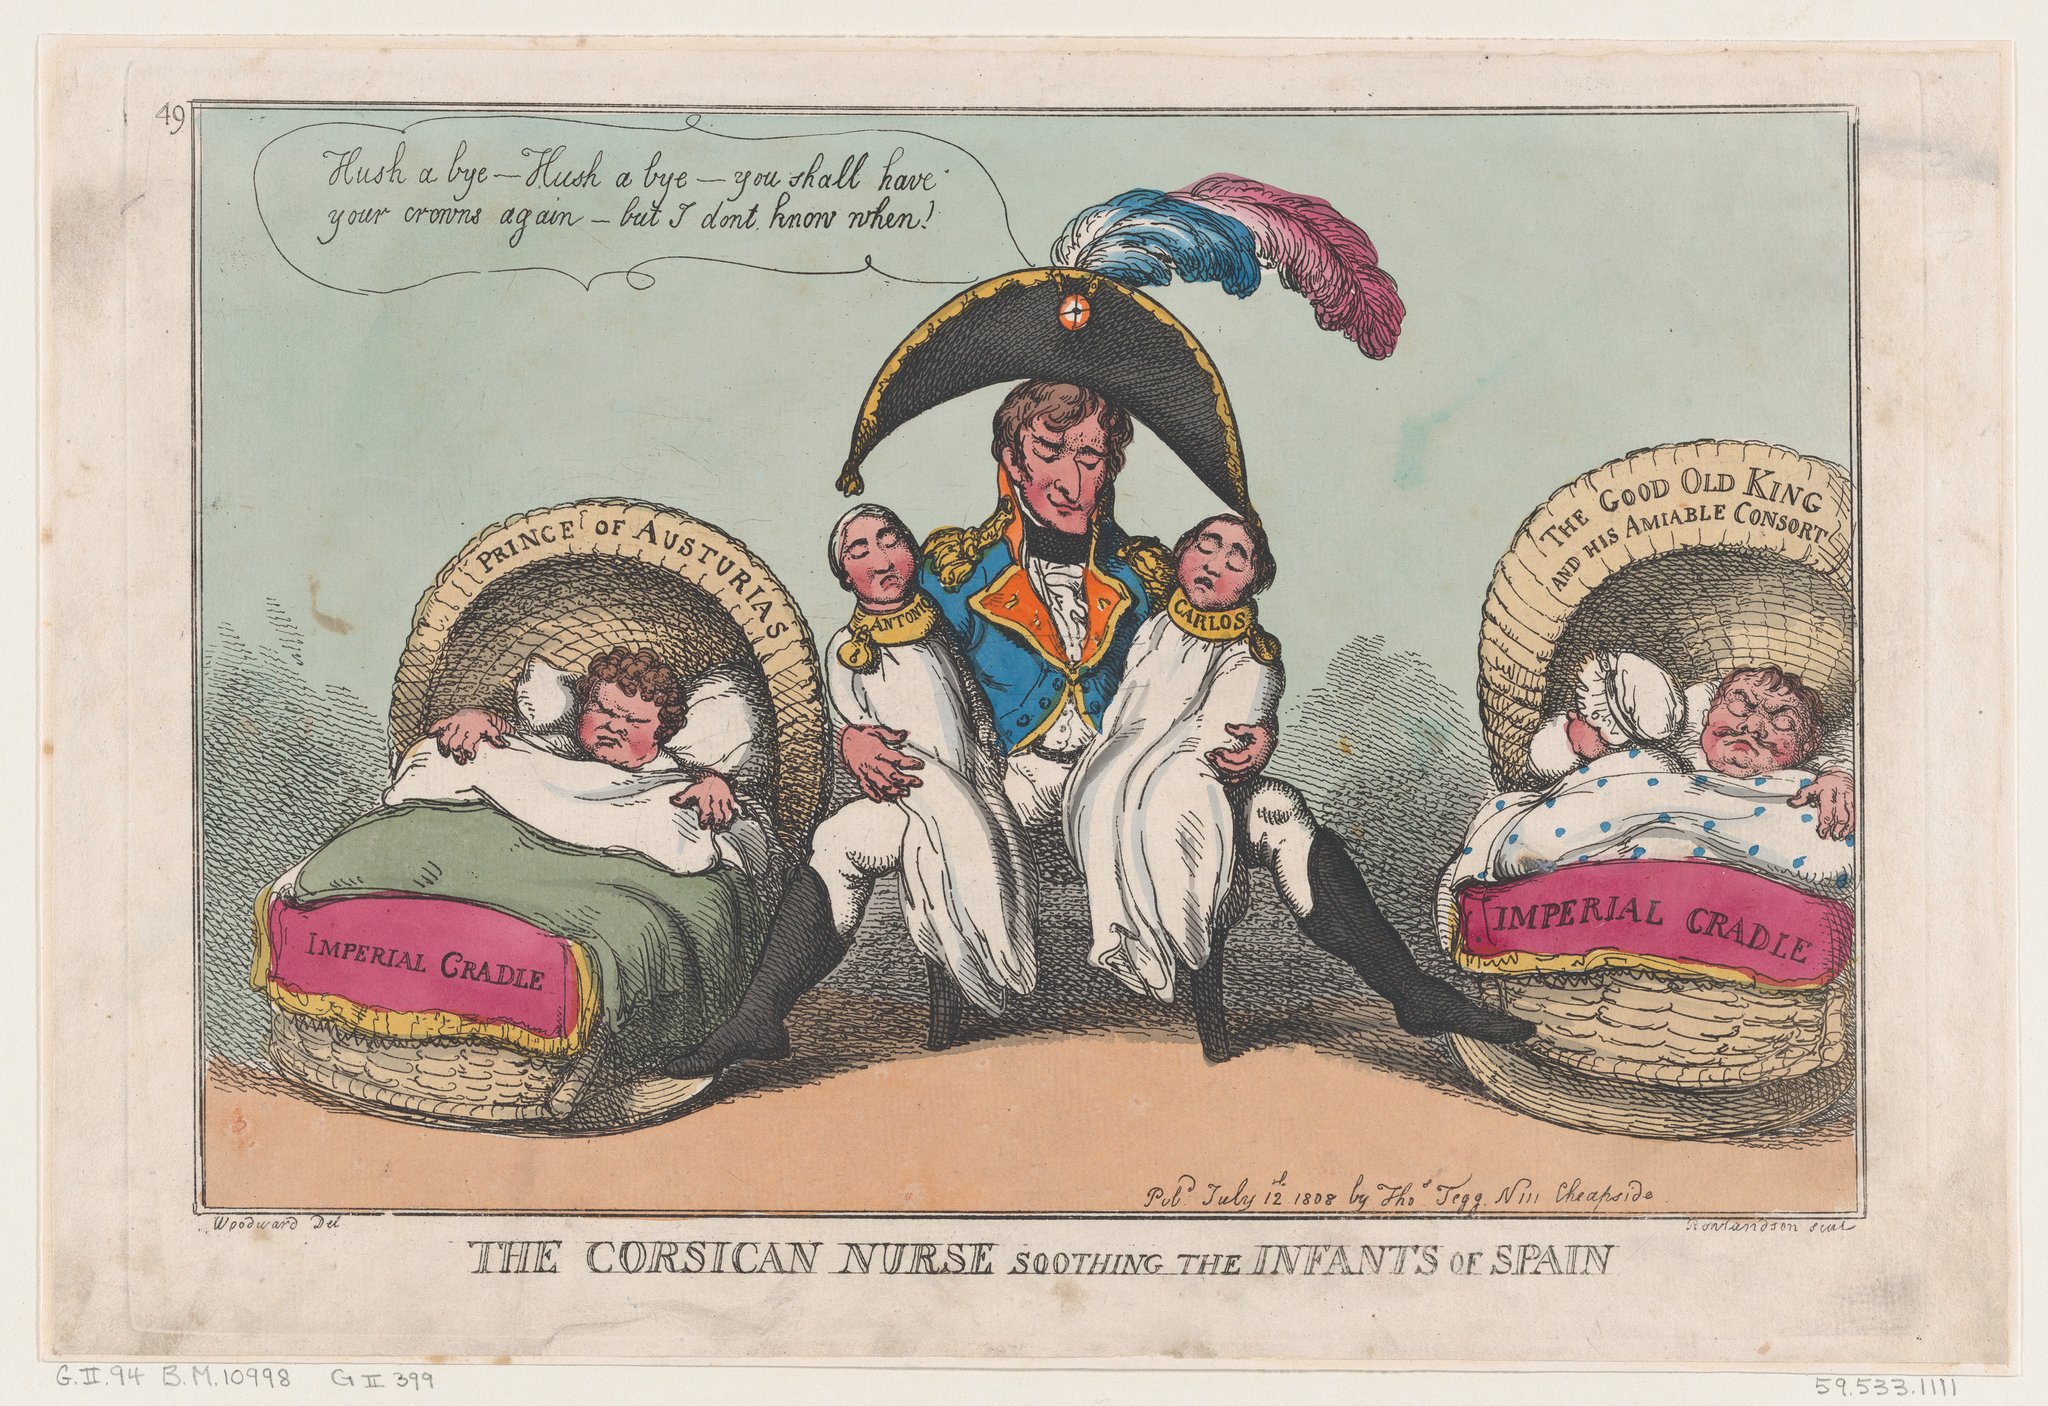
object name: print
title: The Corsican Nurse Soothing the Infants of Spain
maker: thomas rowlandson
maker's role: artist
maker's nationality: british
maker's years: 1757-1827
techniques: etching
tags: satire,napoleon i,men,politics